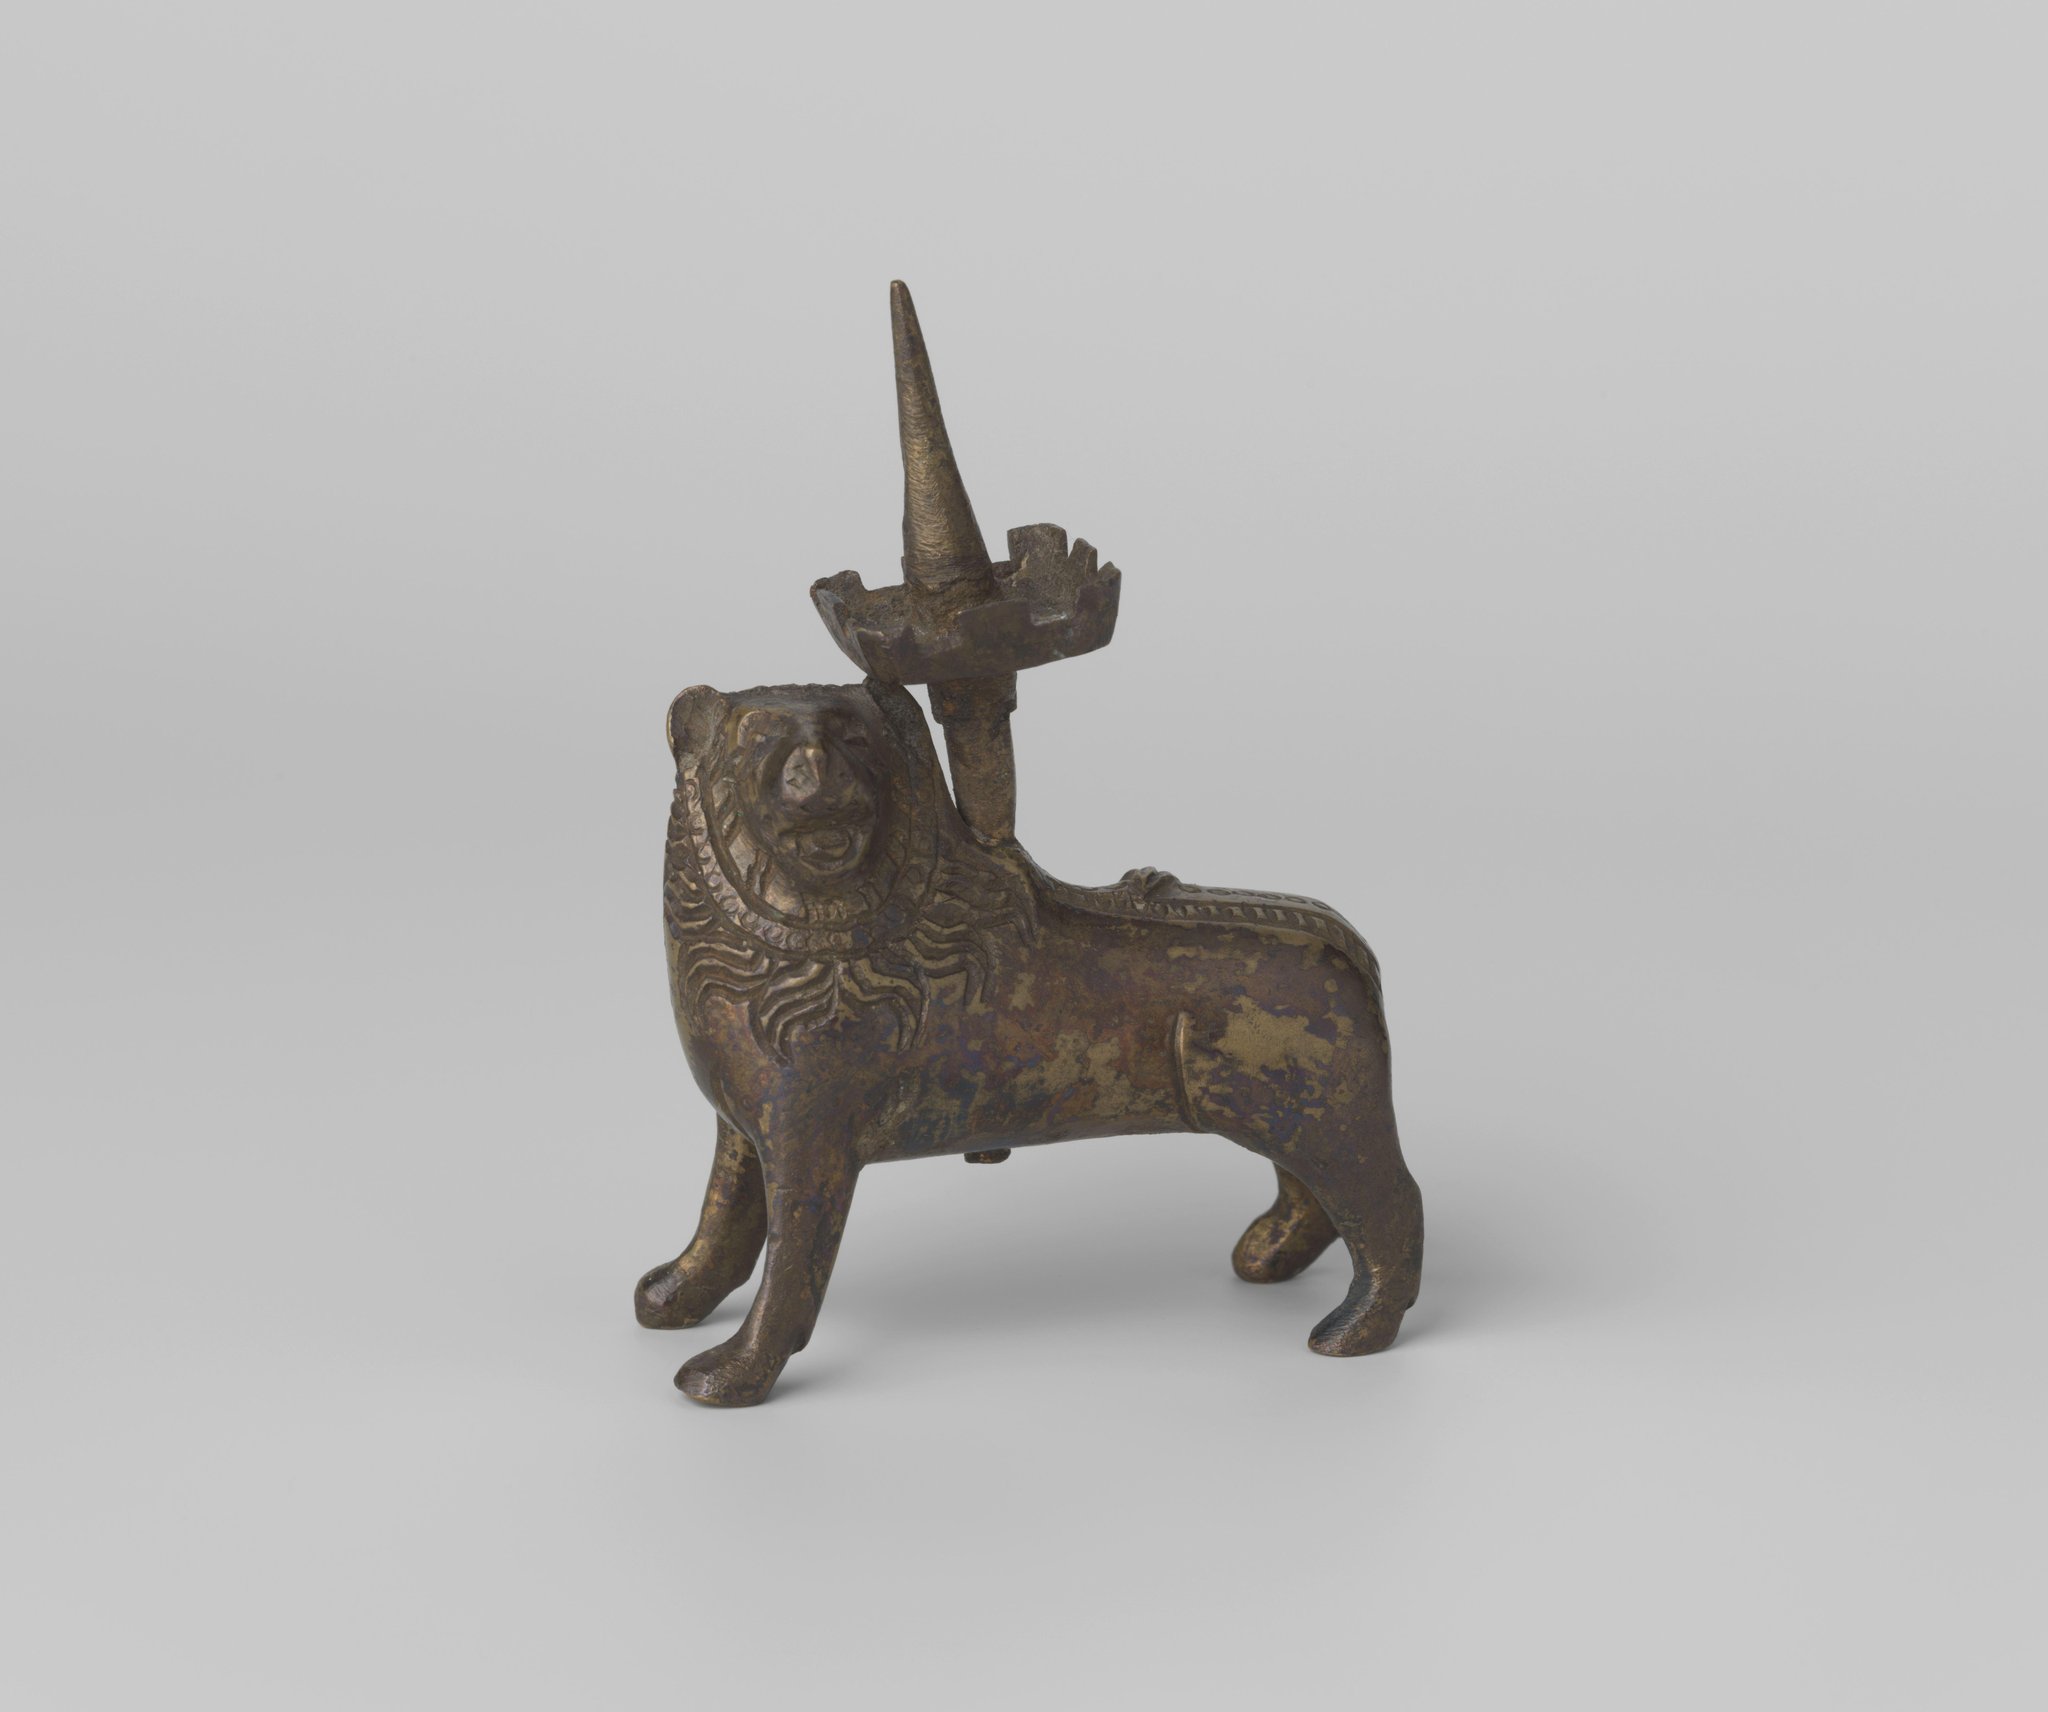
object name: candlestick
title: Kandelaar in de vorm van een leeuw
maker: Anonymous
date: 1275-1325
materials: copper alloy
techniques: casting, metalworking, engraving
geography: germany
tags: beasts of prey, predatory animals: lion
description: Candlestick, in the form of a lion. Bronze or brass. Western Europe, 14th century.